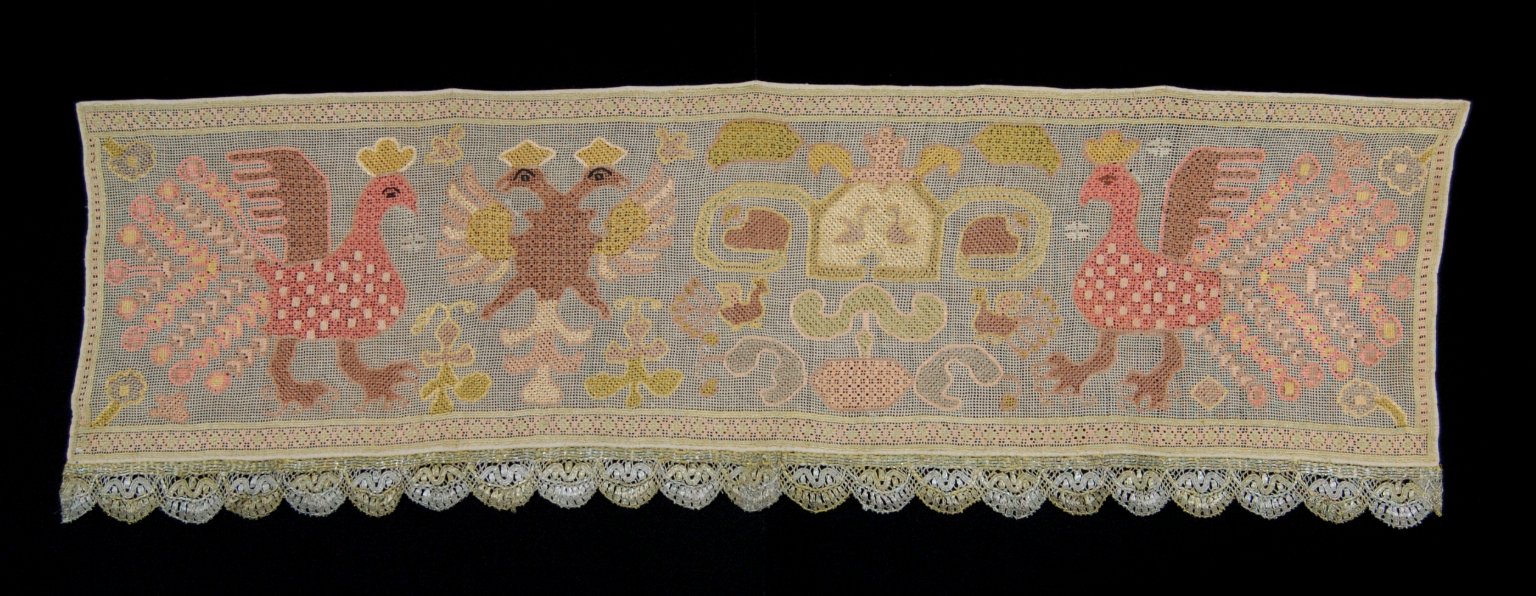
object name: border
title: Bed curtain border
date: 1800-1850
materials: linen, silk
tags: eagles,peacocks